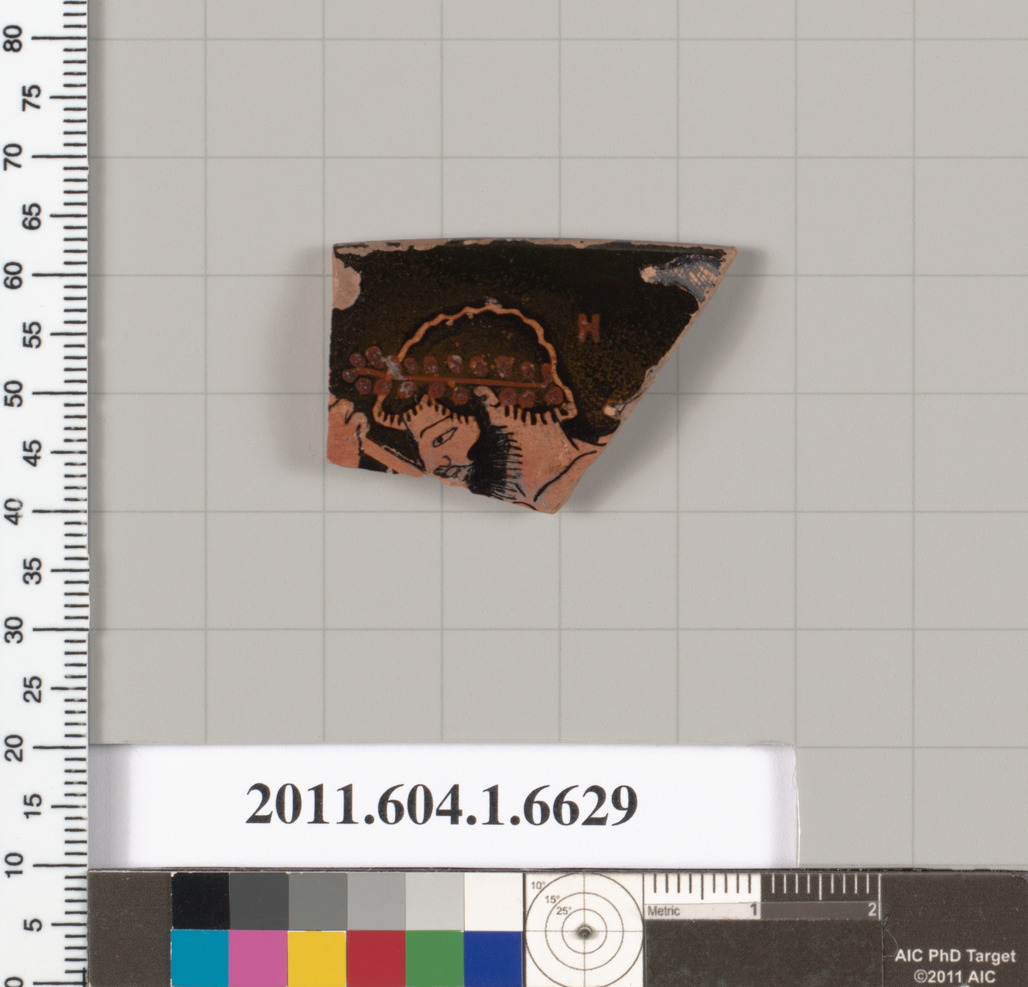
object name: kylix fragment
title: Terracotta rim fragment of a kylix (drinking cup)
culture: greek, attic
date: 490-470 BCE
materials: terracotta